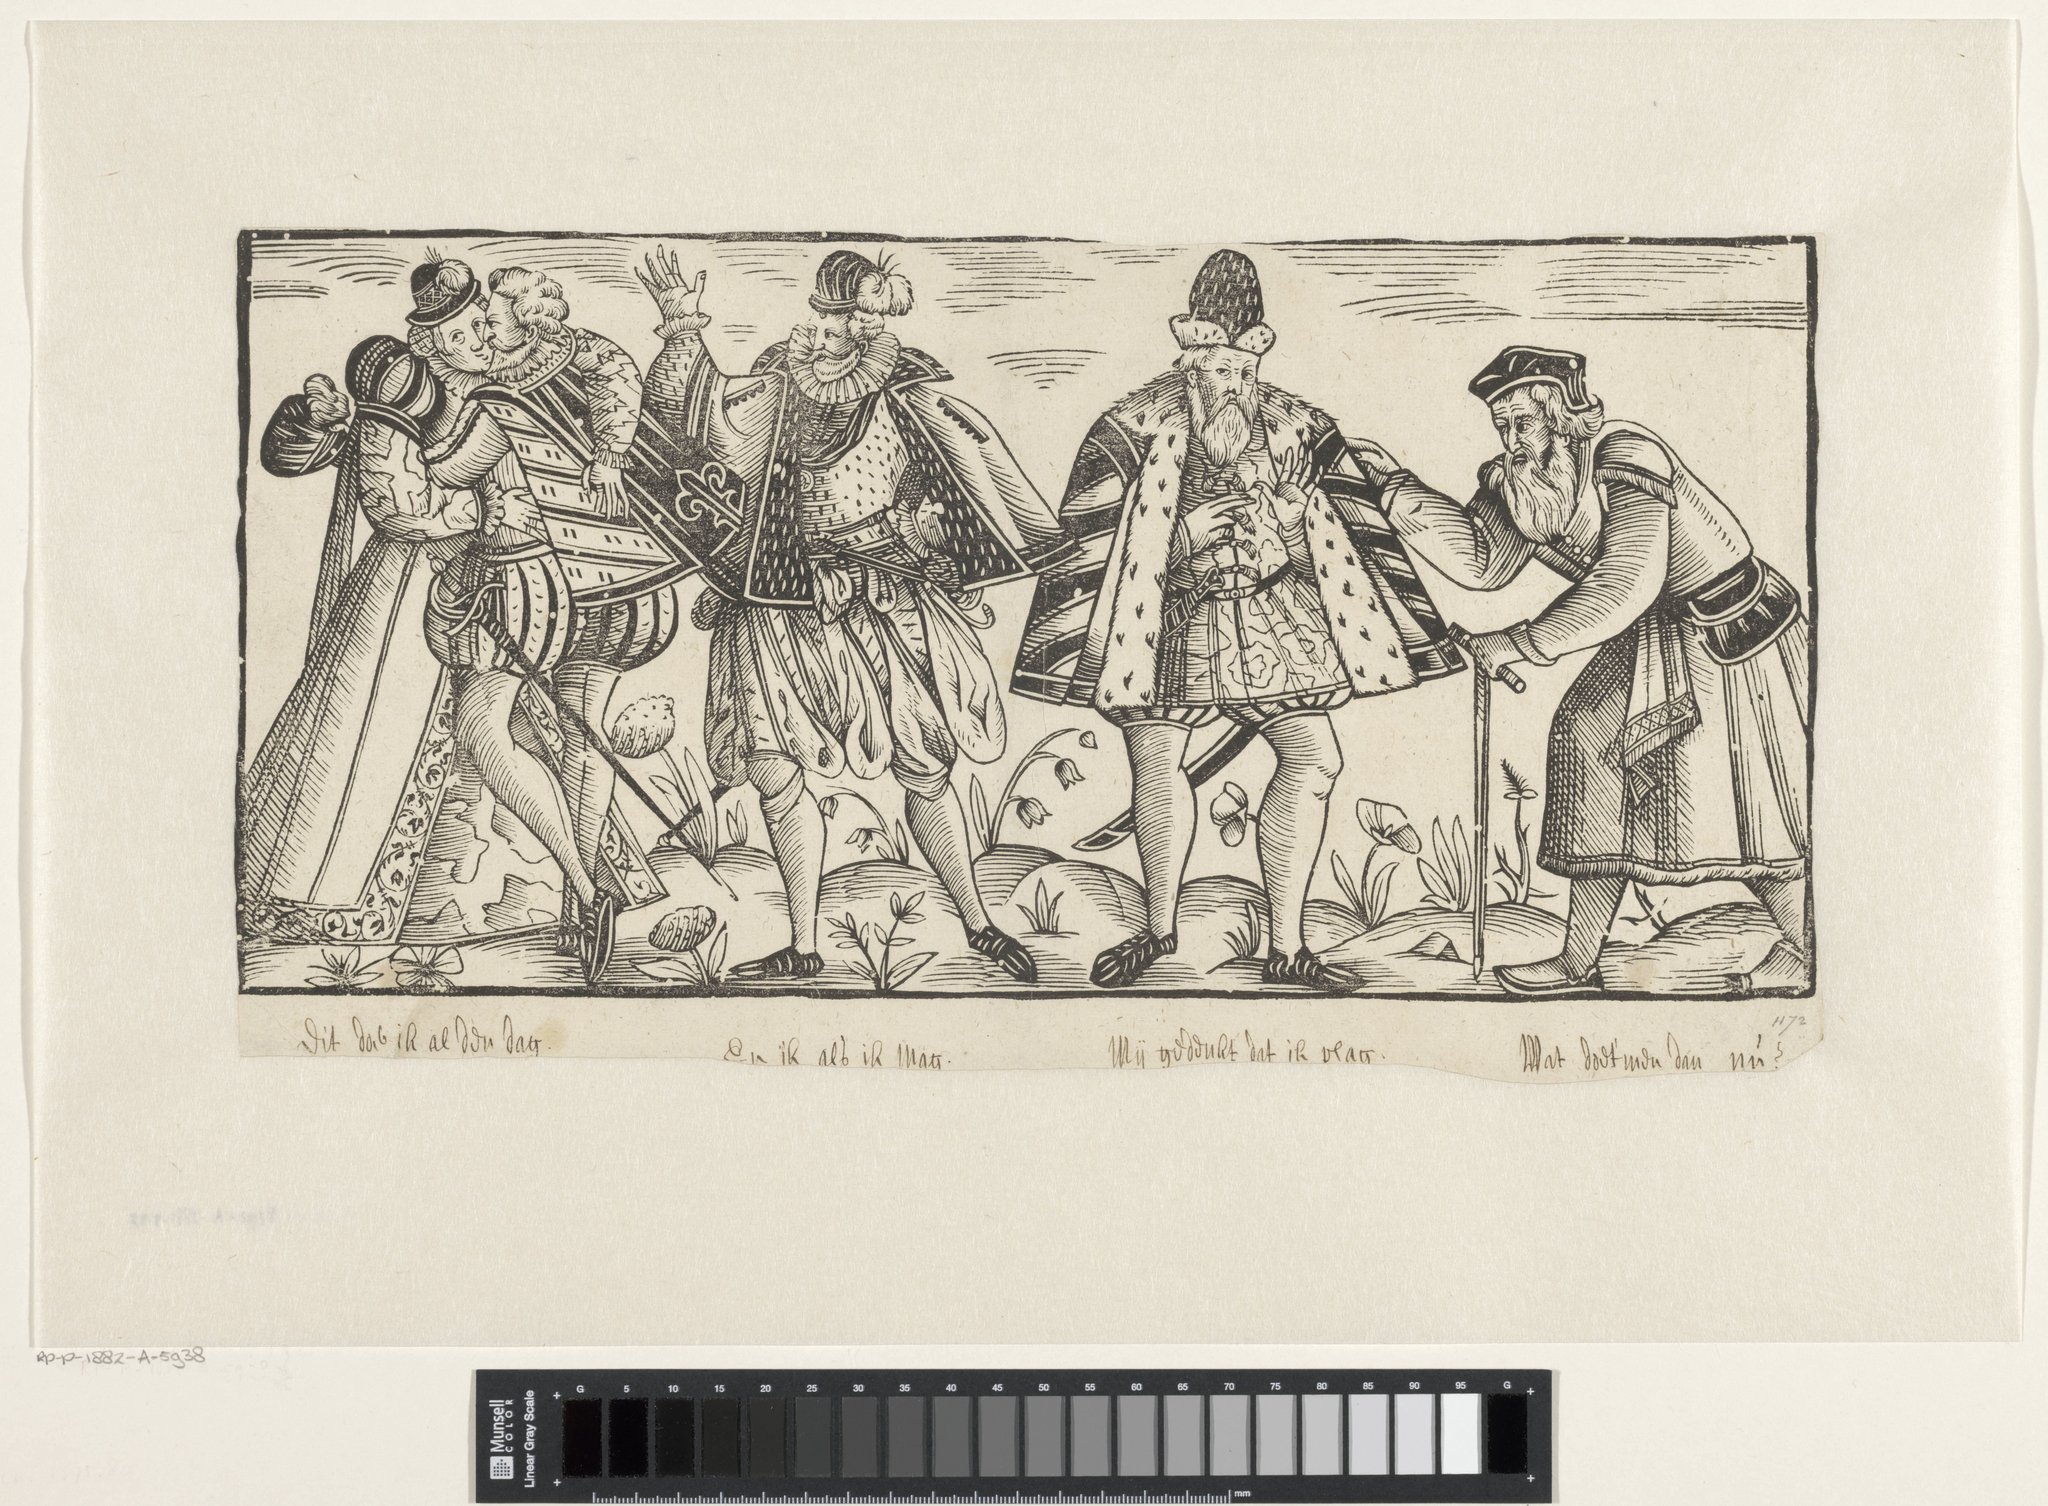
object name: print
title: Kussend jong paar, een man in de kracht van zijn leven, een grijsaard en een stokoude man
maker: Anonymous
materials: paper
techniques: woodcut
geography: netherlands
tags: human races; peoples; nationalities (+ sex and age), the ages of man, clothes, costume (+ women's clothes), proverbs, sayings, etc., clothes, costume (+ men's clothes)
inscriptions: inscription: ‘Dit doe ik al den dag En ik als ik mag Mij gedenkt dat ik vlag Wat doet men dan nu?’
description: Vier mannen in verschillende leeftijden op een rij naast elkaar staand. Links een jongeman die een dame omhelst. Daarnaast een volwassen man met opgeheven arm. Als derde op de rij een man op leeftijd, gekleed in korte cape, muts op het hoofd, op zijn vingers tellend. Geheel rechts een oude man, krom lopend, leunend op een stok. Verwijzingen naar de seksuele capaciteiten van de man in verschillende levensfasen.